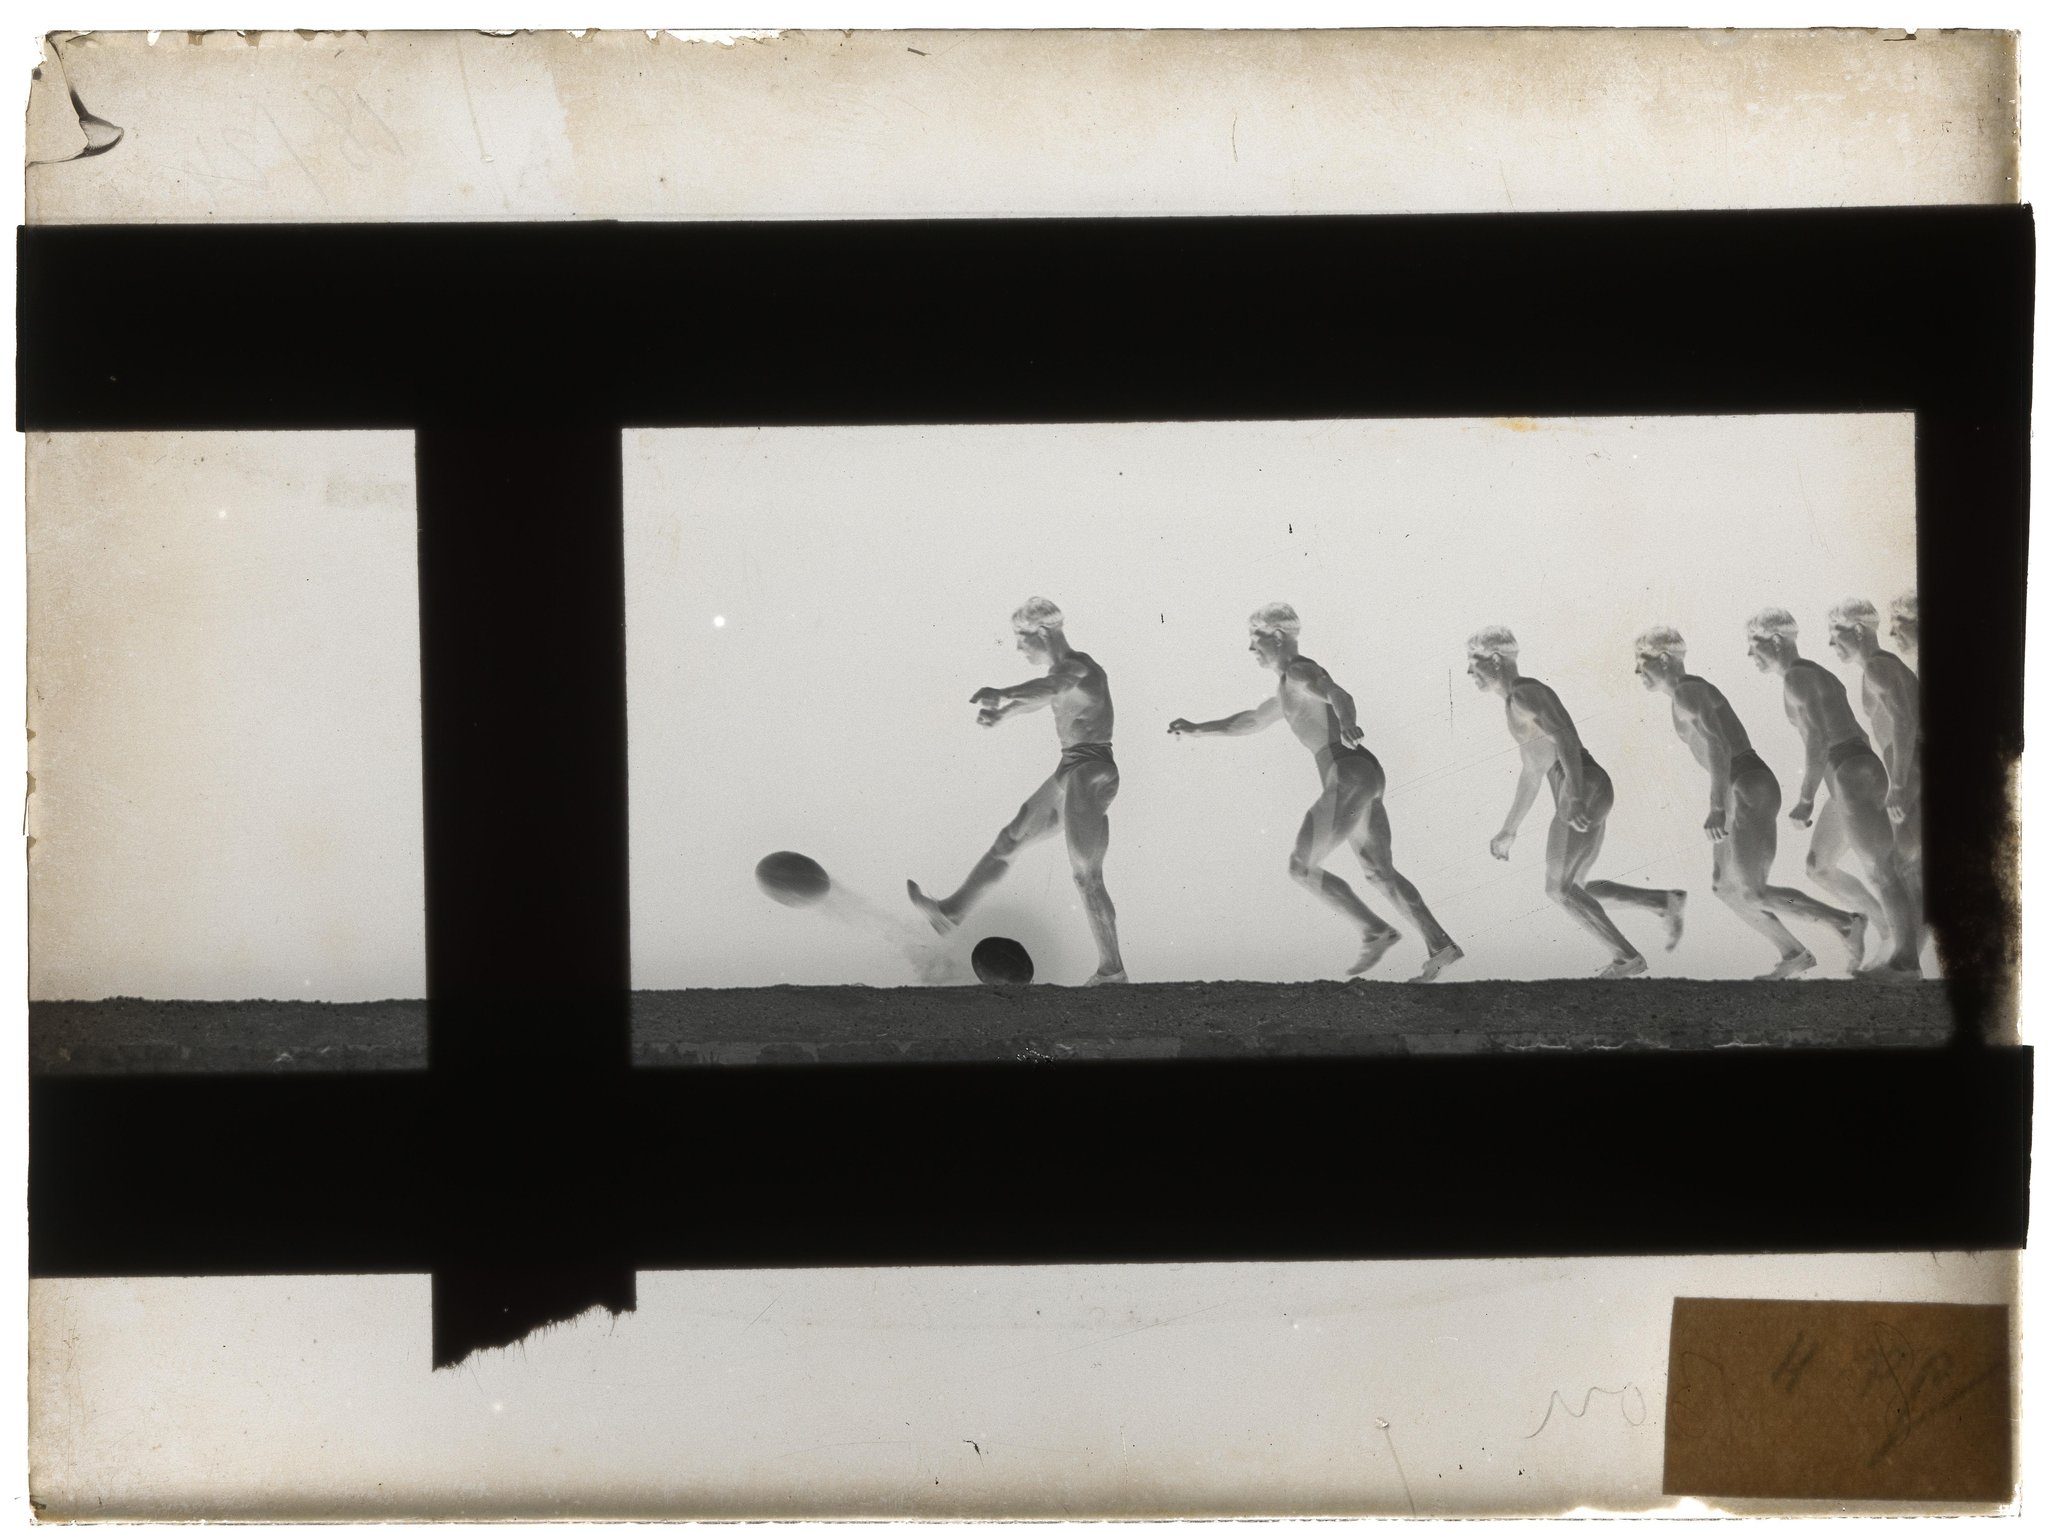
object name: glasnegatief, glasplaatnegatief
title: Man neemt aanloop en schopt de bal weg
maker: étienne-jules marey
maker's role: fotograaf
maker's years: 1830-1904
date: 1882-1890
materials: glass, paper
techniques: gelatin glass negative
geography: france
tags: movements of the human body, kicking ball (children's games), adult man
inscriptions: inscription: ‘Id H’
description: Bij de negatieven zijn ook de duplicaatnegatieven en moderne afdrukken die voor de boekpublicatie vervaardigd zijn.